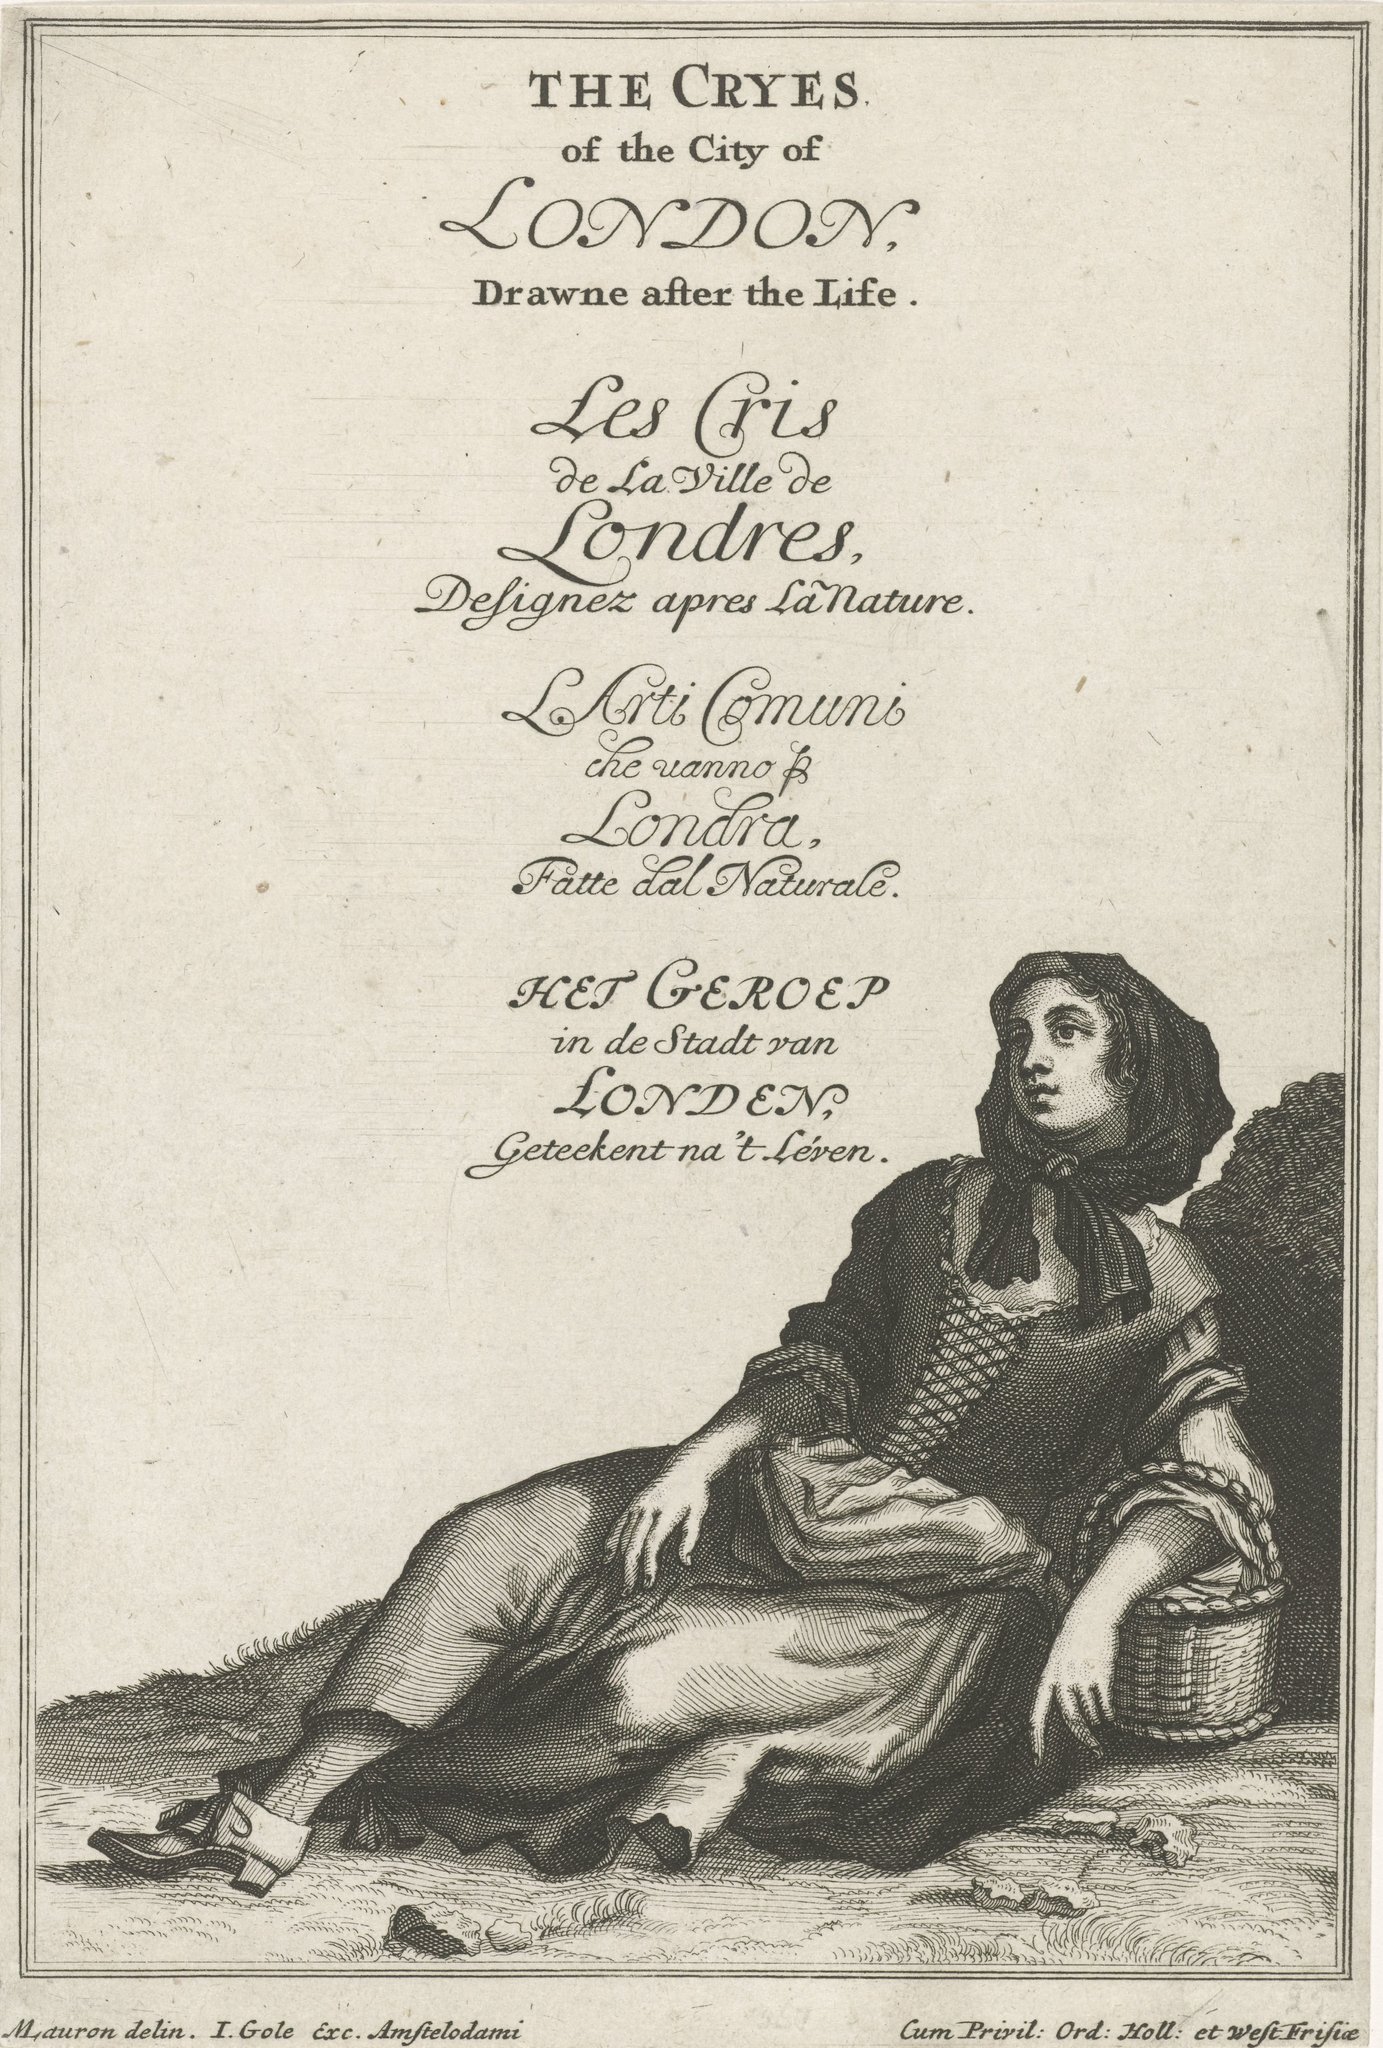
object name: print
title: Het Geroep in de Stadt van Londen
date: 1688-1724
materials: paper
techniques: engraving, etching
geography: amsterdam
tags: lying figure - aa - female human figure, 'cris de paris', cries of london, etc. - bb - women engaged in trade and commerce, london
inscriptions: collector's mark: Lugt 2228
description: Een vrouw ligt op de grond, een mandje om haar linkerarm. Centraal de titel van de prentserie in het Engels, Frans, Italiaans en Nederlands. De serie van tien heeft als onderwerp straatventers in Londen.